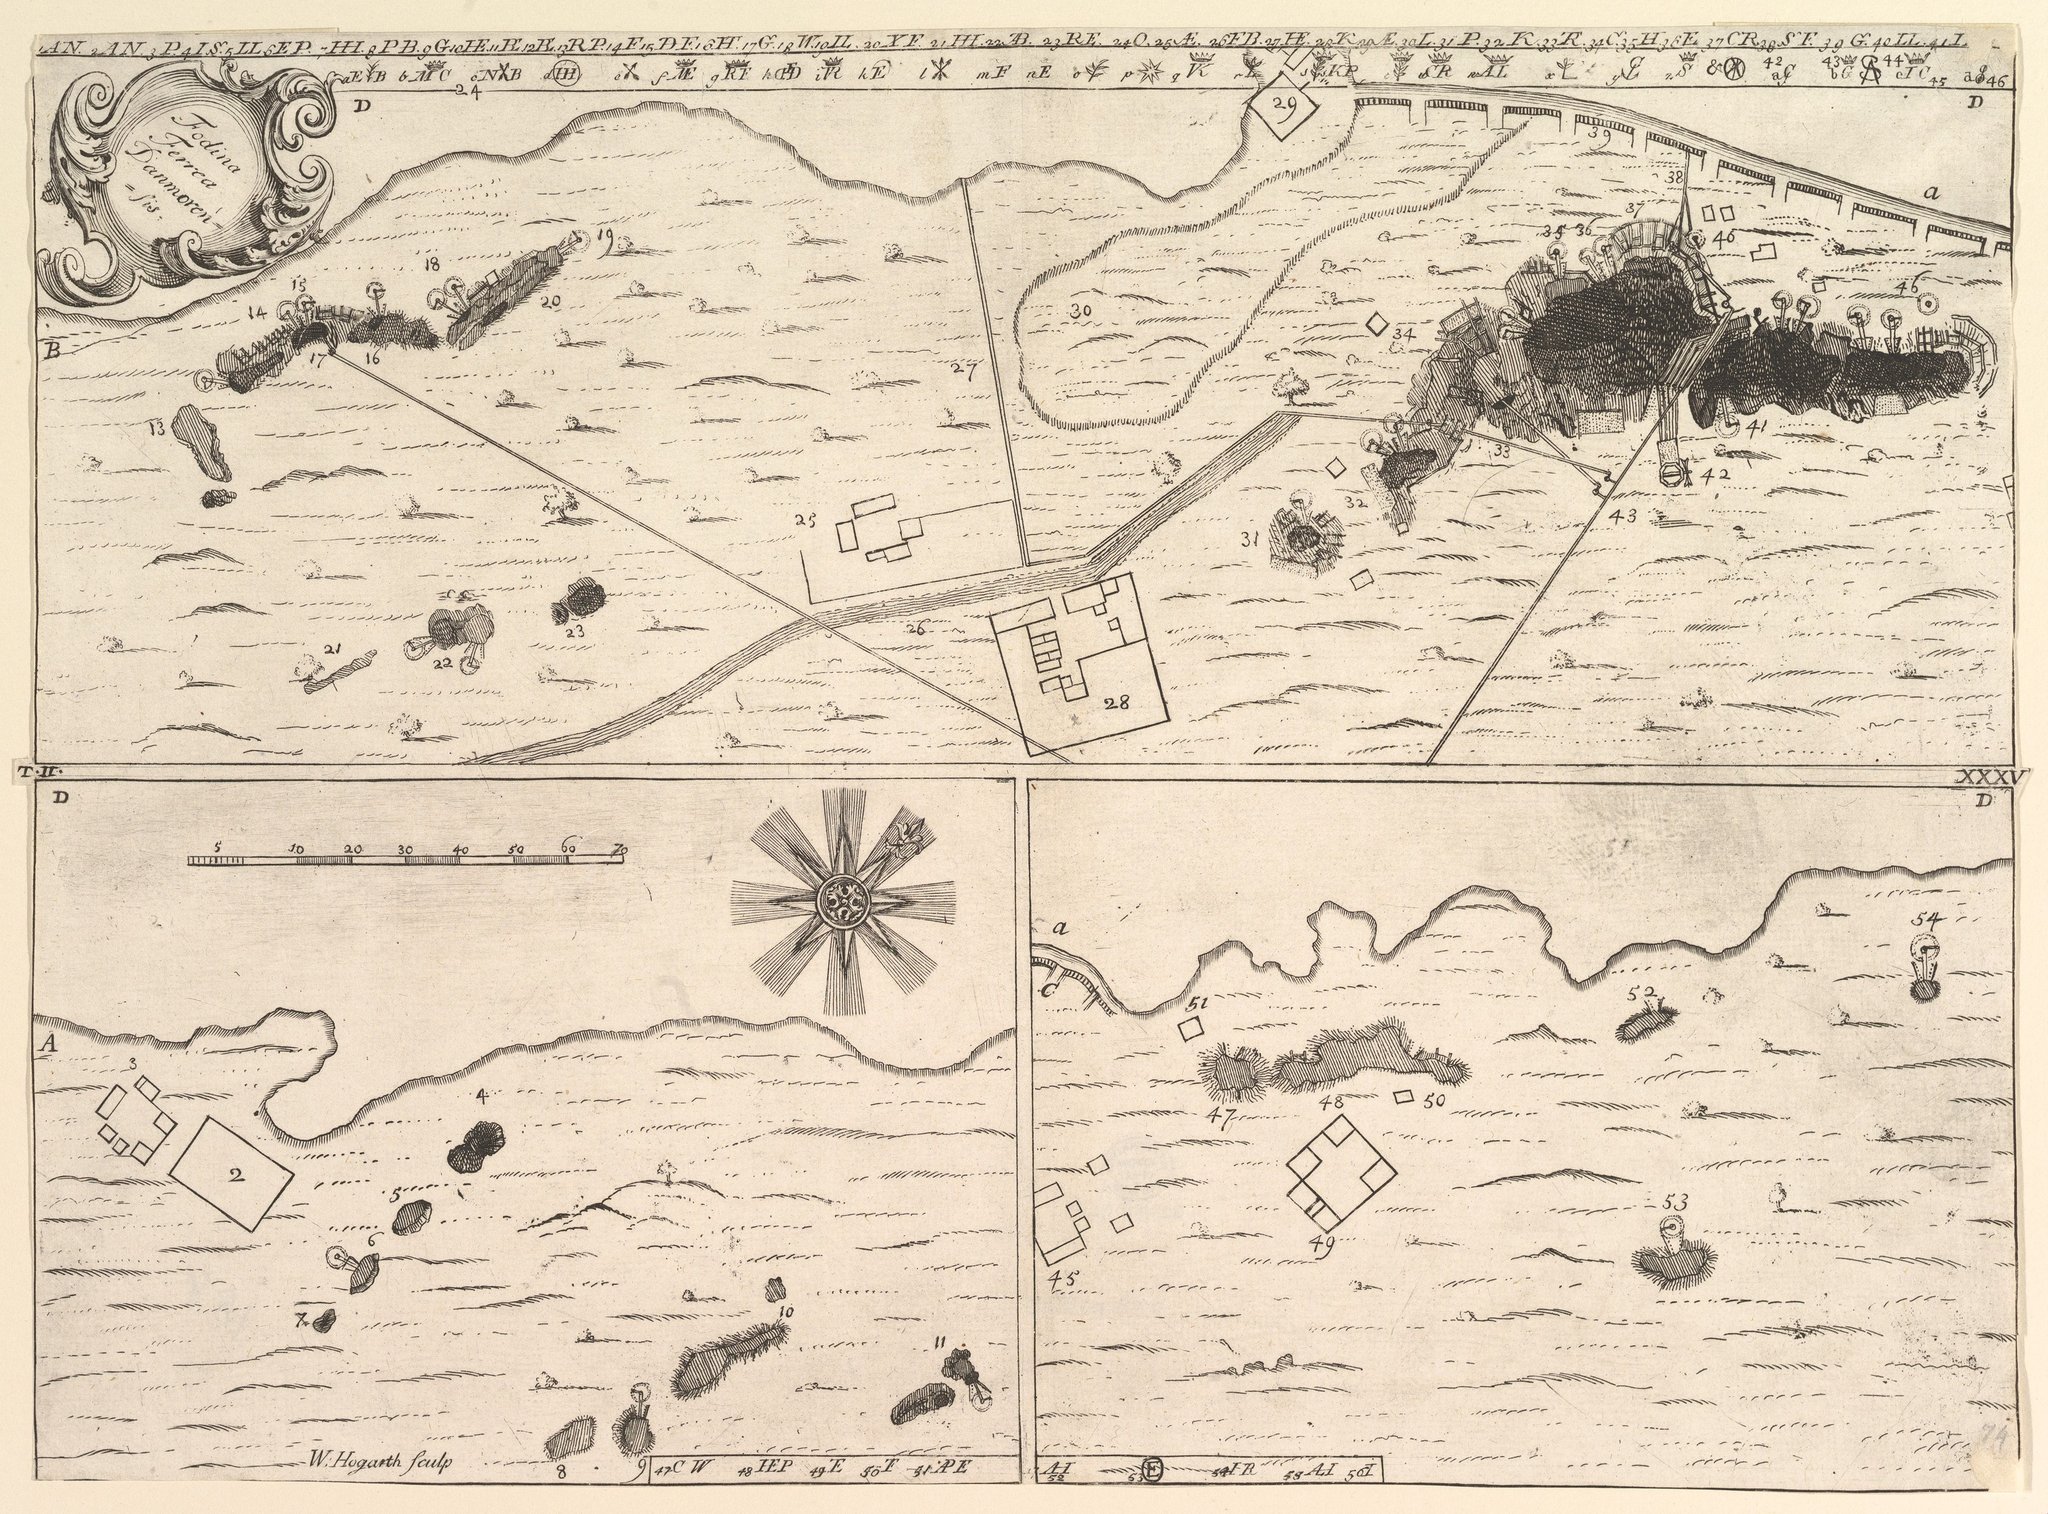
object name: print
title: Fodina ferrea Danmorensis – A Danish Iron Mine (Aubry de La Mottraye's "Travels throughout Europe, Asia and into Part of Africa...," London, 1724, vol. II, pl. 35)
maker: william hogarth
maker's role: artist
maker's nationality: british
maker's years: 1697-1764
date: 1723-1724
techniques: engraving, etching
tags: maps